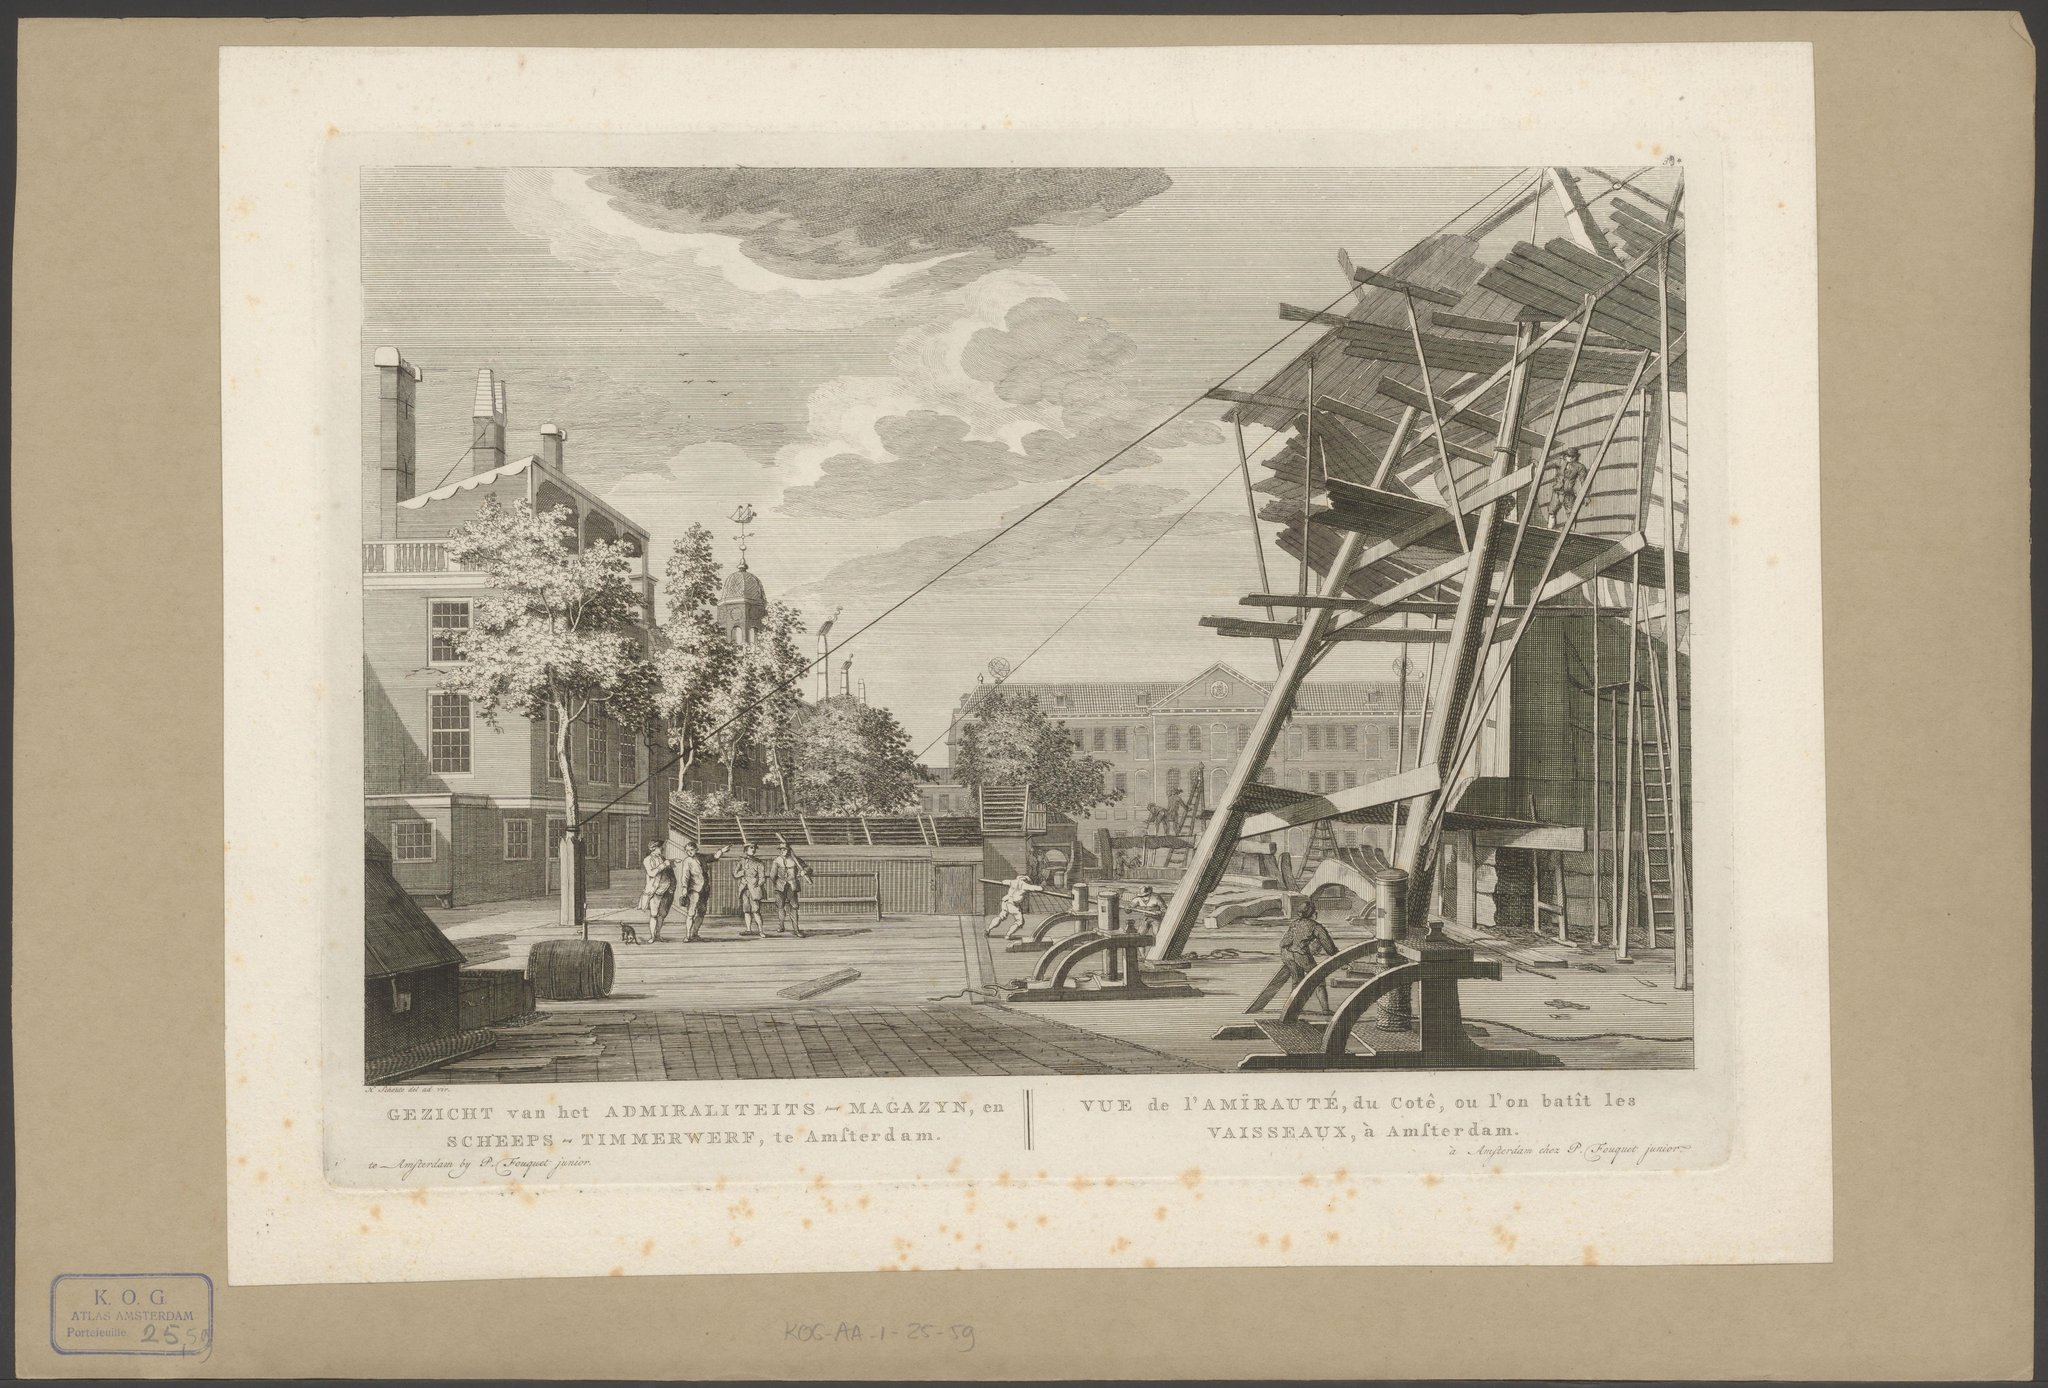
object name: print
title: Gezicht op de Admiraliteitswerf en 's Lands Zeemagazijn te Amsterdam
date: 1770-1783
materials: paper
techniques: engraving, etching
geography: amsterdam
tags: large-scale structure for storage, e.g.: warehouse, depot, silo, building a ship, ship under construction, shipyard, shipdock, ammunition store, arsenal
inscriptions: collector's mark: ‘25.59’ Lugt 1641b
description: Deze prent is ook gebruikt in de zogenaamde Atlas van Fouquet.* Pierre Fouquet gaf vanaf 1760 stadsgezichten van Amsterdam - naar tekeningen van verschillende kunstenaars, gemaakt door verschillende prentmakers - uit. Deze prenten werden aanvankelijk los of in series verkocht. Zoals toen gebruikelijk kon de koper de prenten zelf laten inbinden. Hiertoe gaf Fouquet tussen 1778 en 1783 een titelblad, plattegrond en inhoudsopgave van de tot dusver 100 uitgegeven prenten uit (1). Gezien de inhoud afhankelijk was van wat de koper had verzameld verschilt de inhoud van de verschillende bewaarde Fouquetatlassen onder deze titel sterk. Ook zijn er exemplaren bekend waar tevens andere prenten aan zijn toegevoegd. Omdat er behoefte bleek aan uitleg bij de platen werd in 1783 een nieuwe versie van de atlas uitgegeven, aangevuld met tekst en twee prenten. De aangegeven volgorde veranderde maar de platen van de al eerder uitgegeven prenten bleven ongewijzigd. Deze uitgave werd in opdracht van Fouquet gedrukt bij Daniël Jean Changuion en Petrus den Hengst (2). Een tiental platen werd bijgewerkt en verscheen, met nieuw impressum, in het vervolg van Wagenaars geschiedenis van Amsterdam, uitgeven door Petrus Conradi en Folkert van der Plaats (3). Een aantal jaar na het overlijden van Fouquet kwam Evert Maaskamp met een nieuwe uitgave van de atlas, met verbeterde tekst en toevoeging van twee prenten. Op alle platen verwijderde hij het oude en liet hij zijn eigen impressum zetten (4). De huidige staat van de prent komt voor in exemplaren van de onder (1) en (2) genoemde werken. * Onder de Atlas van Fouquet of Fouquetatlas verstaan we de hieronder vermelde publicaties (1), (2) en (4). (1). Afbeeldingen van de wyd-vermaarde koopstad Amsterdam benevens des zelvs voornaamste gebouwen en gezigten alle naar het leeven getekend / Receuil des edifices les plus considerables et des plus belles vues, de la fameuse ville d'Amsterdam, dessinées d'après nature. Amsterdam: Pierre Fouquet, 1778-1783. (2). Nieuwe atlas, van de voornaamste gebouwen en gezigten der stad Amsterdam, met derzelver beknopte beschryvingen. 2 delen. Amsterdam: Daniël Jean Changuion en Petrus den Hengst [in opdracht van Pierre Fouquet], 1783. (3). Stijl, Simon. Amsterdam, in zyne geschiedenissen, voorregten, koophandel, gebouwen, kerkenstaat, schoolen, schutterye, gilden en regeeringe, beschreeven. Om te dienen ten vervolge op het werk van Jan Wagenaar (…). 10 delen. Amsterdam en Harlingen: Petrus Conradi en Folkert van der Plaats, 1788-1801. (4). Nieuwe atlas, van de voornaamste gebouwen en gezigten der stad Amsterdam. Met derzelver beknopte beschryvingen. Amsterdam: Evert Maaskamp, 1805. * Het aantal vermelde staten is gebaseerd op het aantal gevonden staten. Mogelijk zijn er meer staten van deze prent. Zie ook RP-P-1905-315.